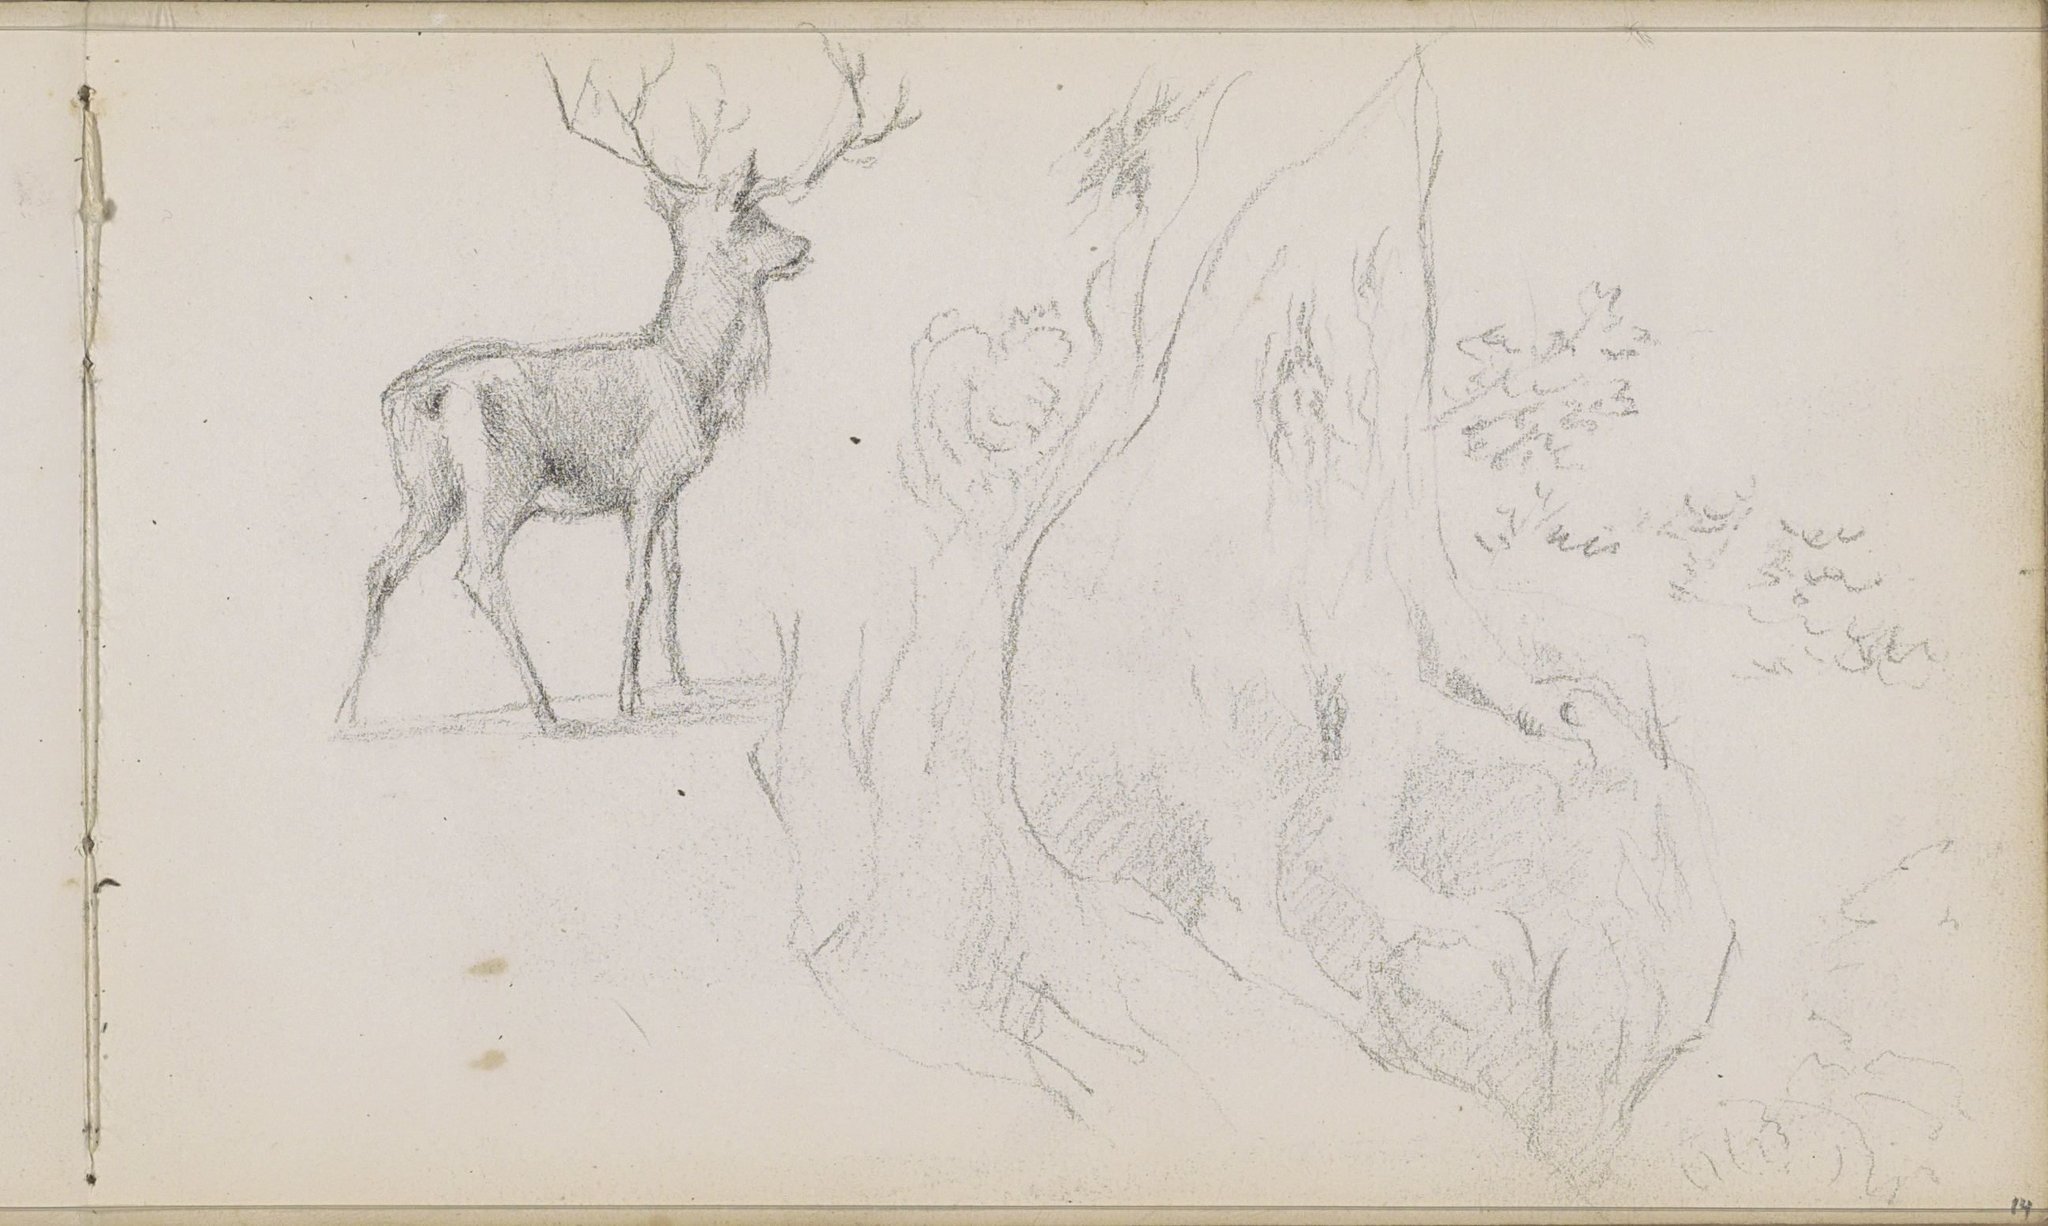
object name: sketchbook leaf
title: Boomwortels en een hert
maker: willem cornelis rip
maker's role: draughtsman, painter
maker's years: 1856-1922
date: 1874-1875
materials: paper, pencil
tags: hoofed animals: deer, trees (+ root, tuber)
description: Blad 14 recto uit een schetsboek met 46 bladen.